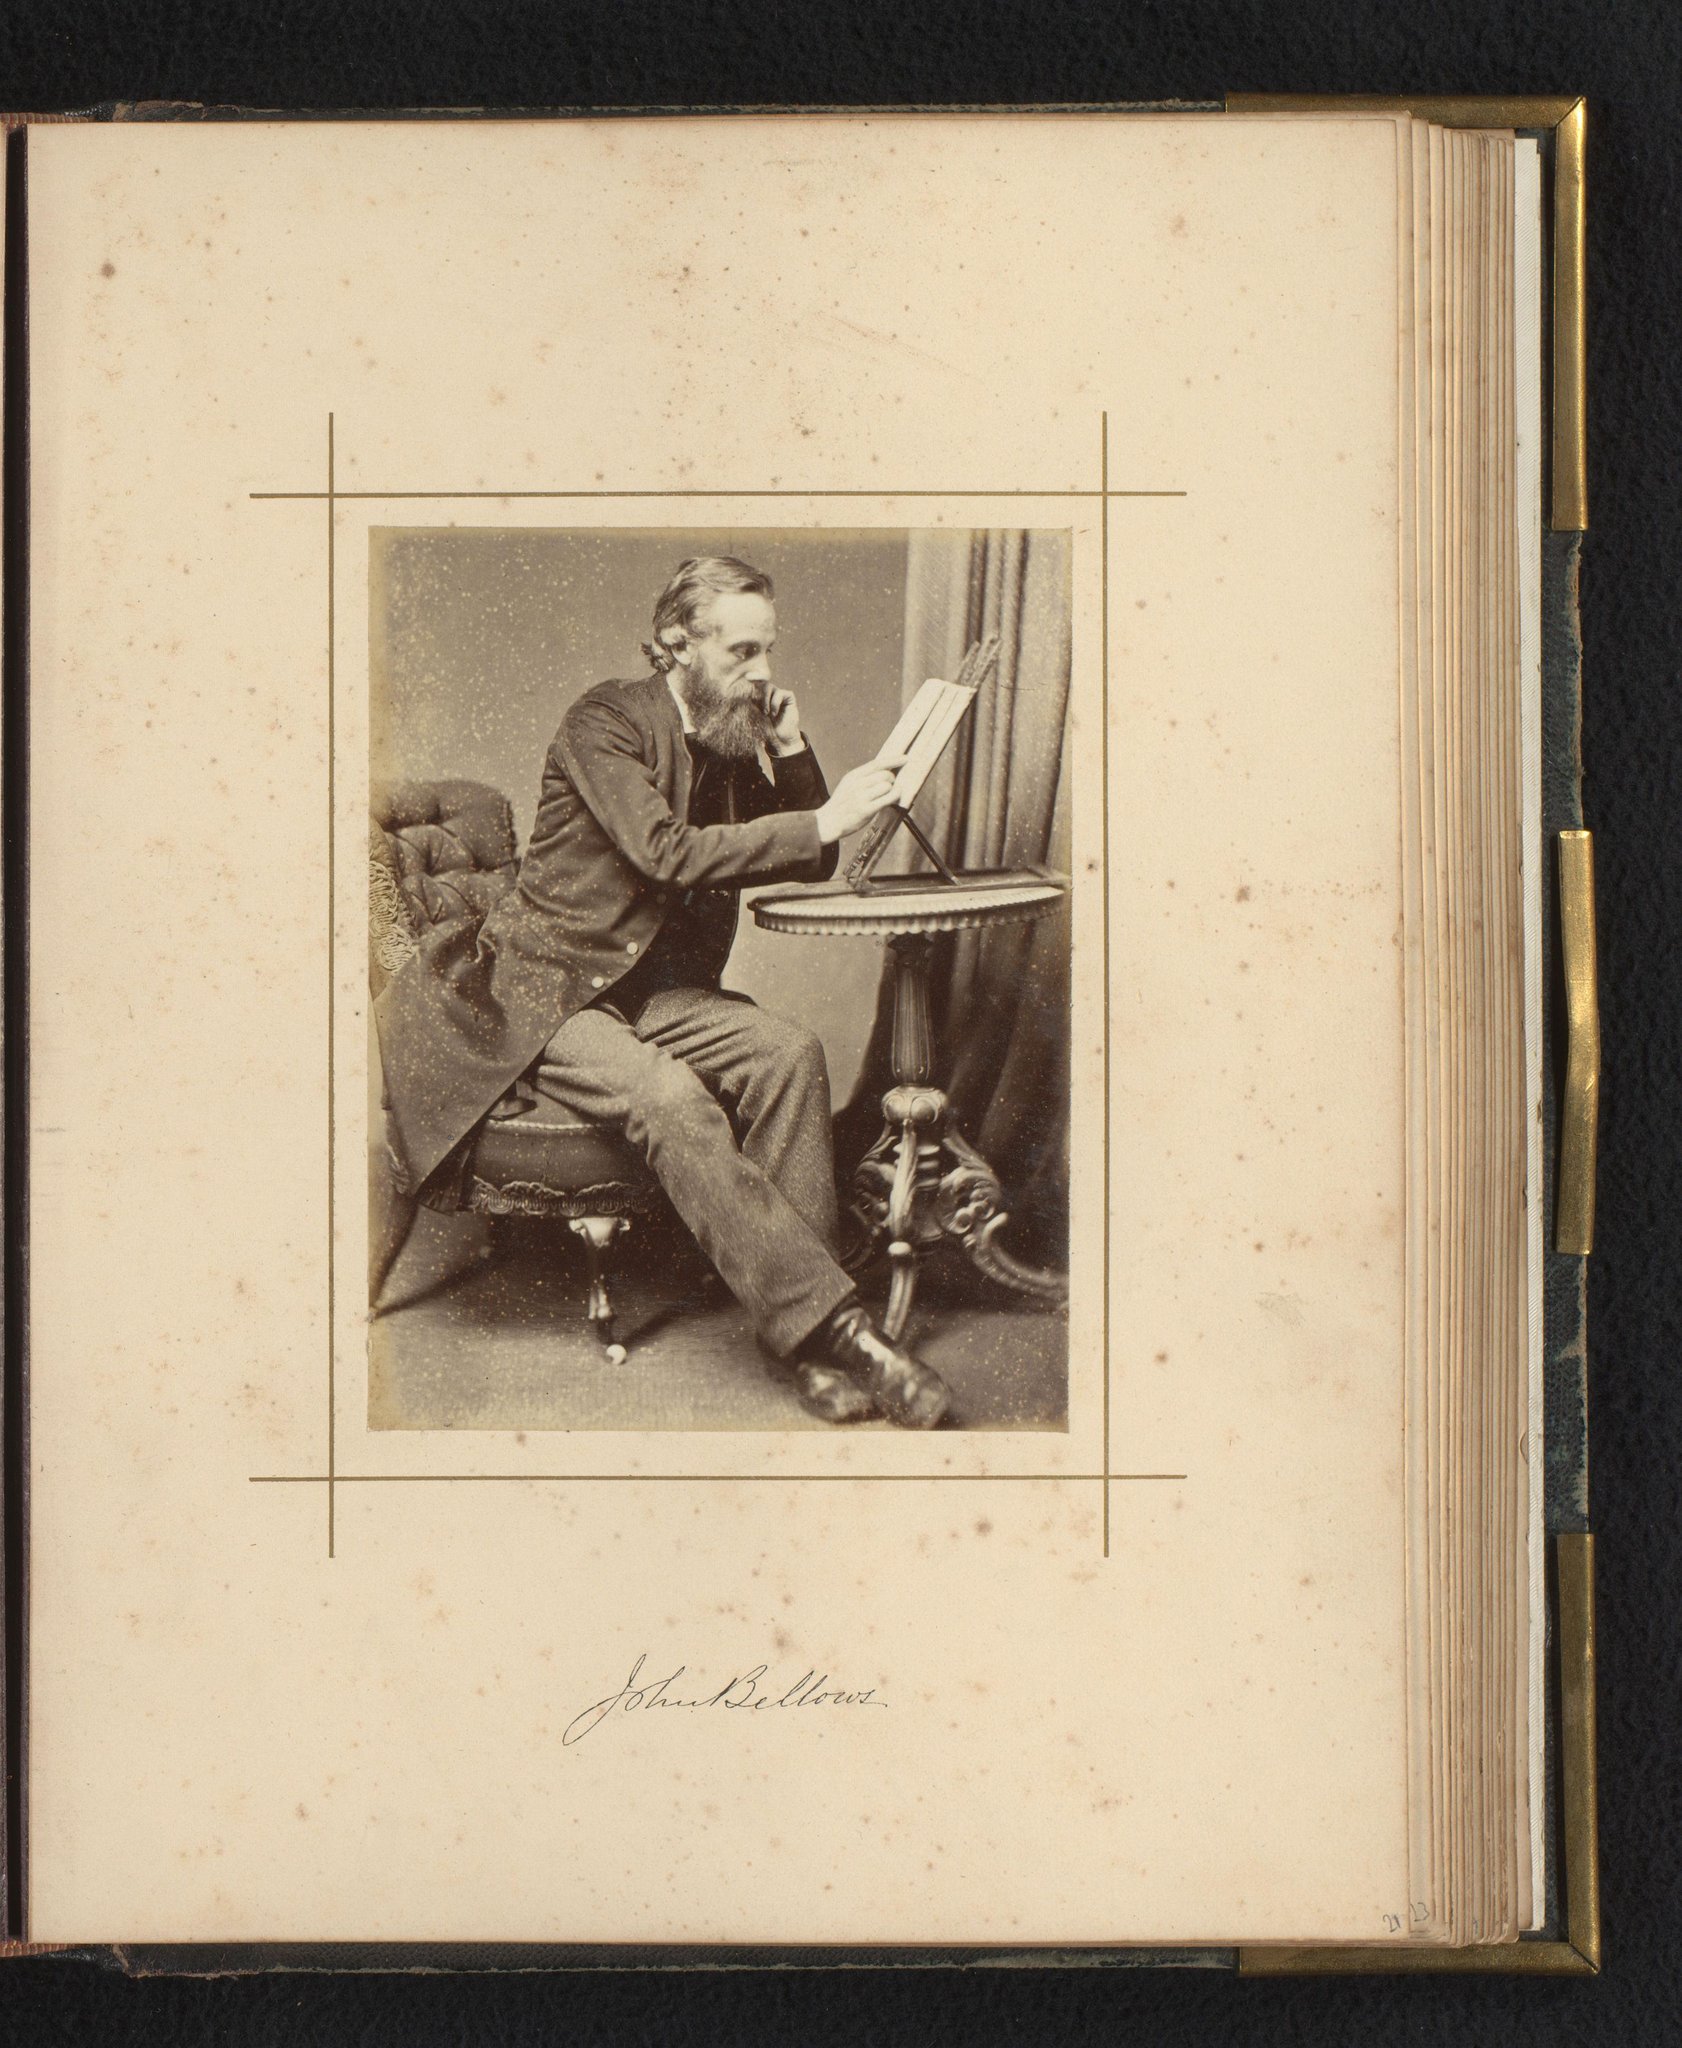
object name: photograph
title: Portret van John Bellows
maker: Anonymous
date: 1866-1871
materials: photographic support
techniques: albumen print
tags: sitting figure, historical persons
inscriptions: name: ‘John Bellows’